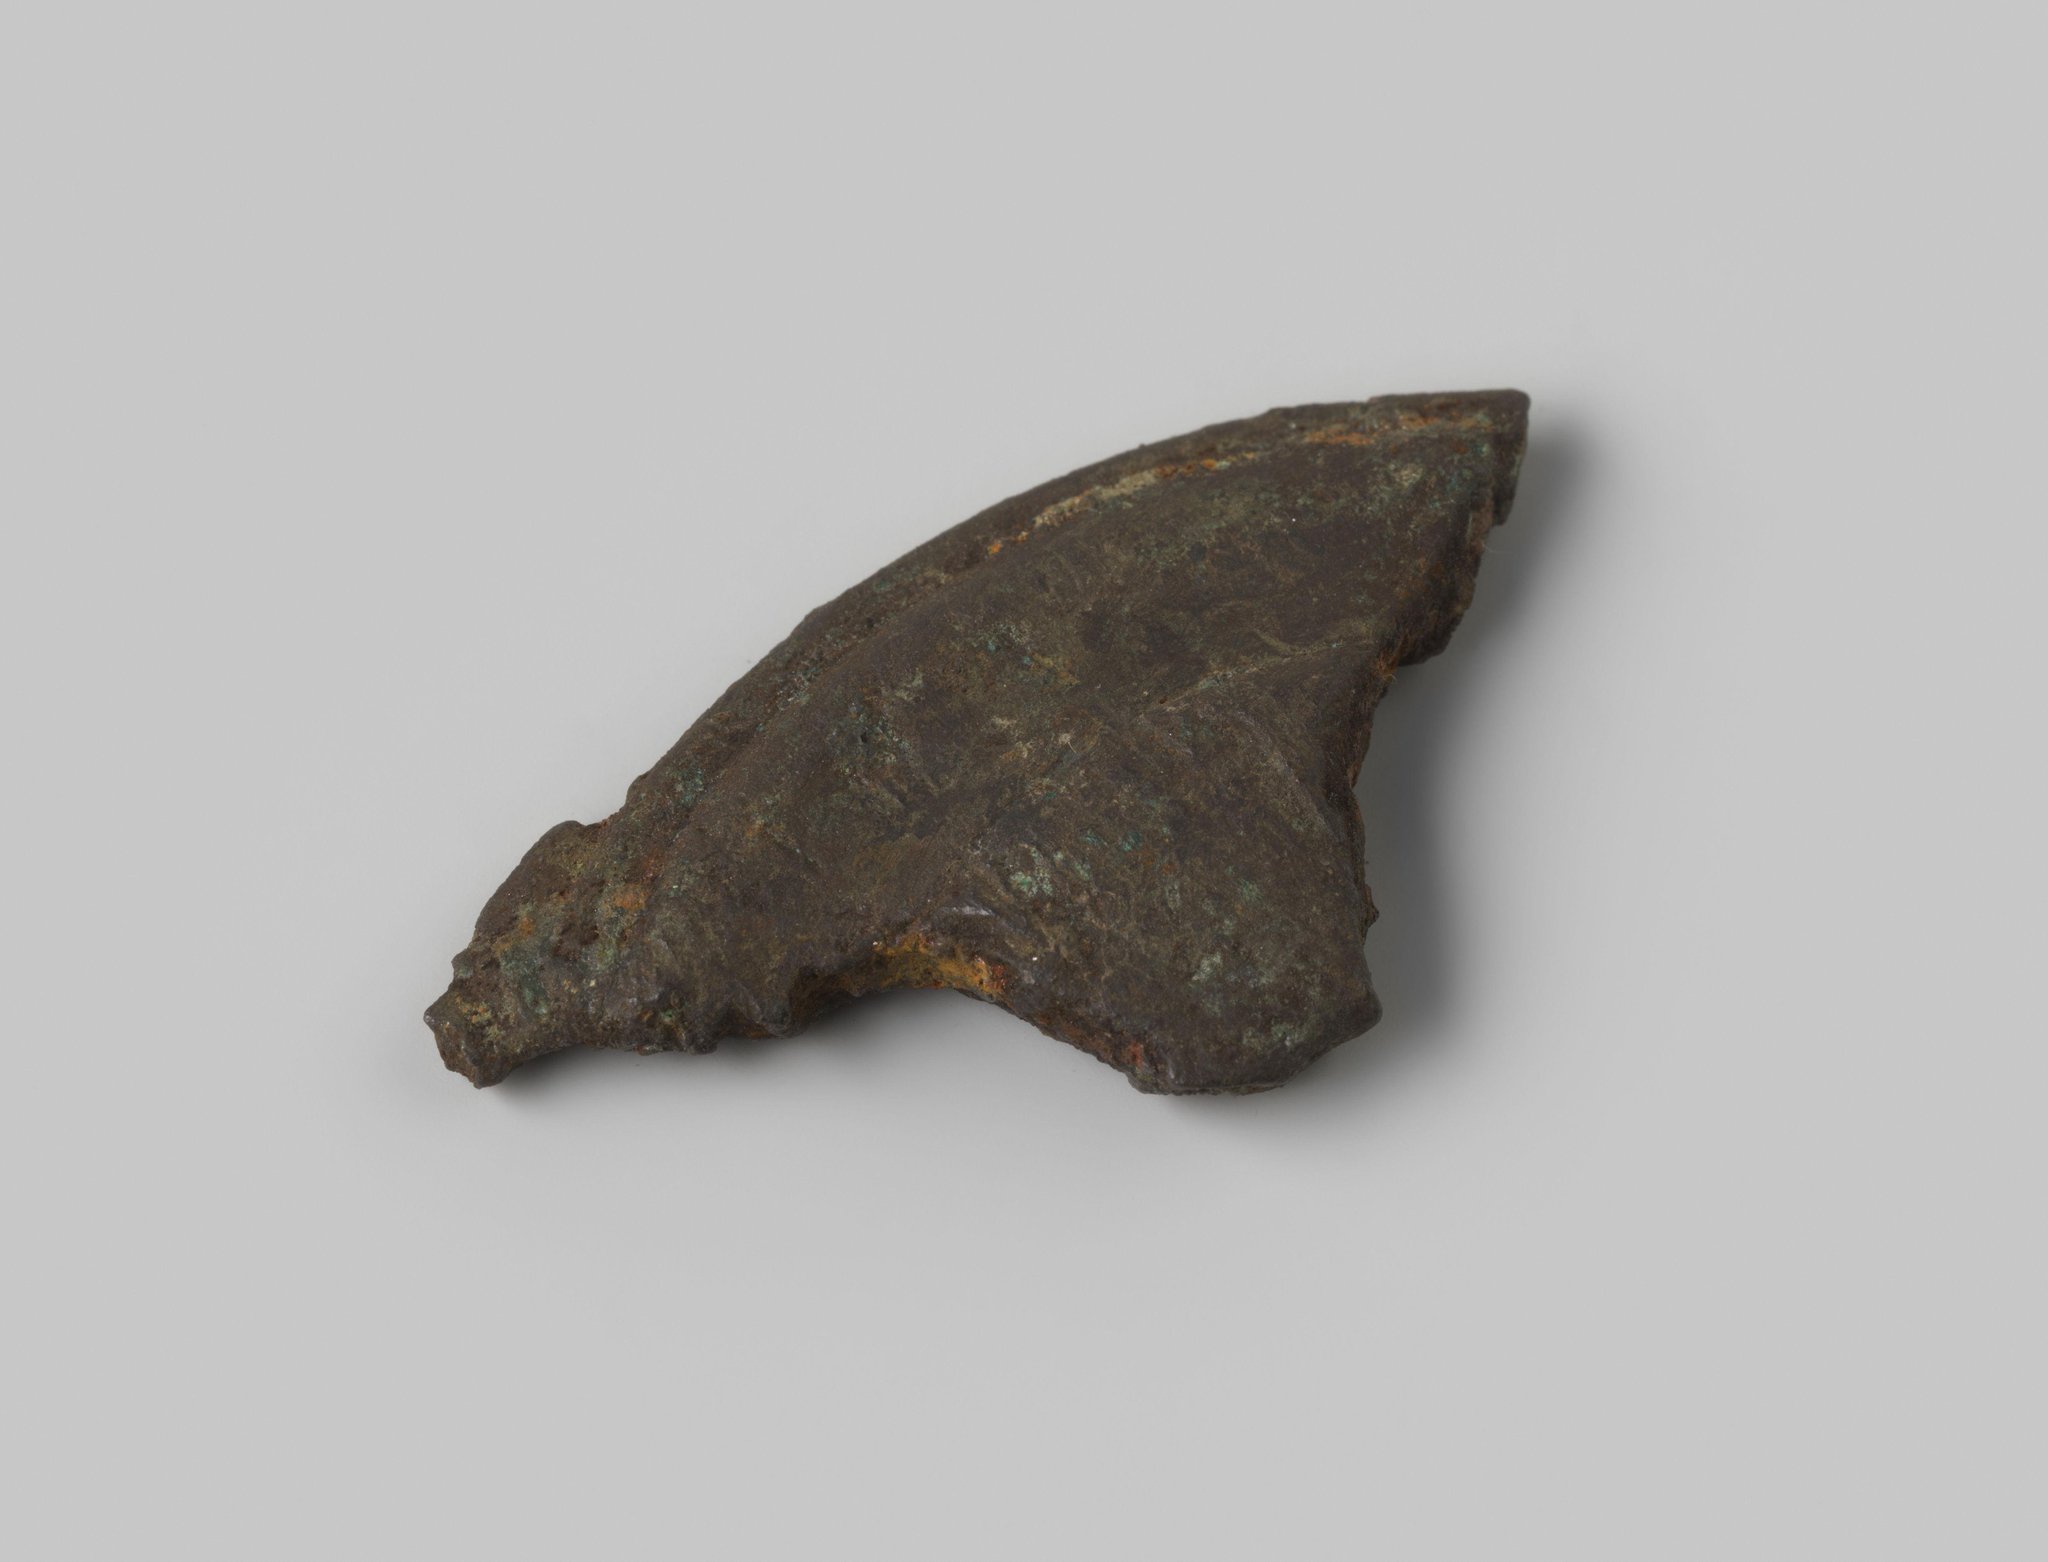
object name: candlestick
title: Fragment voet van een kandelaar uit het wrak van de Oost-Indiëvaarder Hollandia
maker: Anonymous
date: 1700-1743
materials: copper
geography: netherlands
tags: verenigde oostindische compagnie, hollandia (schip), annet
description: Candlestick, foot; fragm of circular foot, flat.